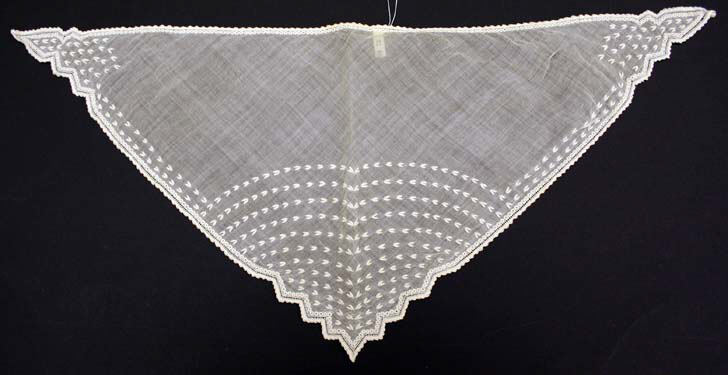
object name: kerchief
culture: american or european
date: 1801-1900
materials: cotton